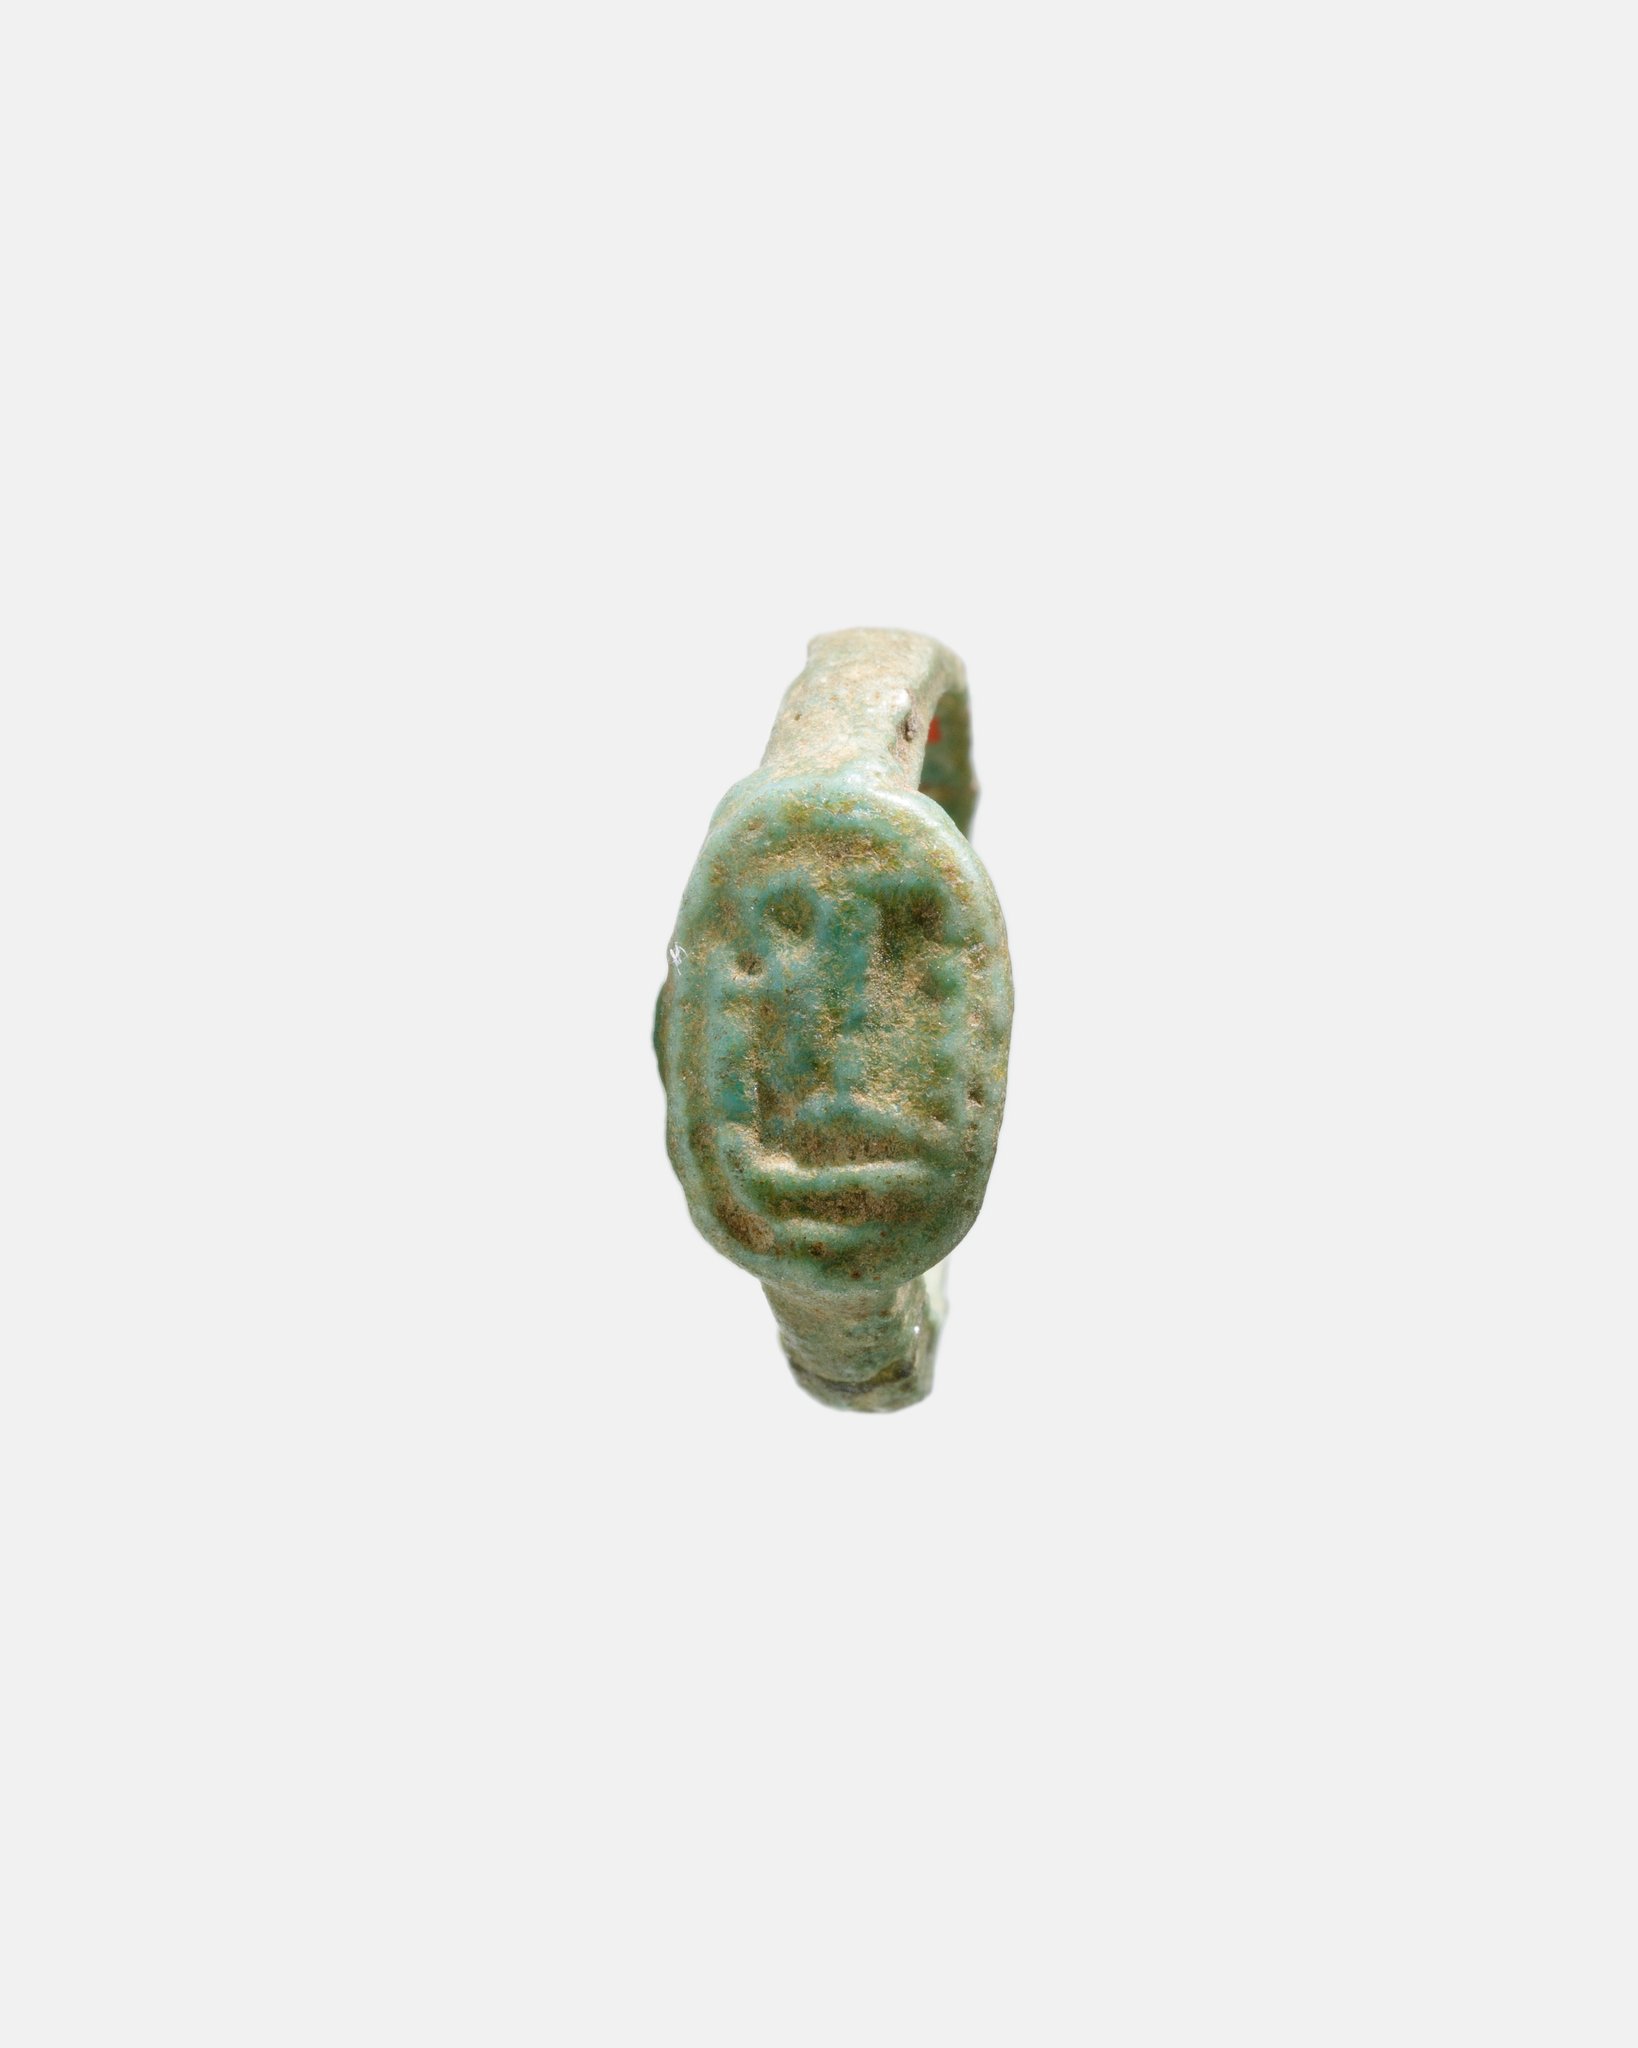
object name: ring, amun re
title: Ring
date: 1550-1070 BCE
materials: faience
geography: northern upper egypt